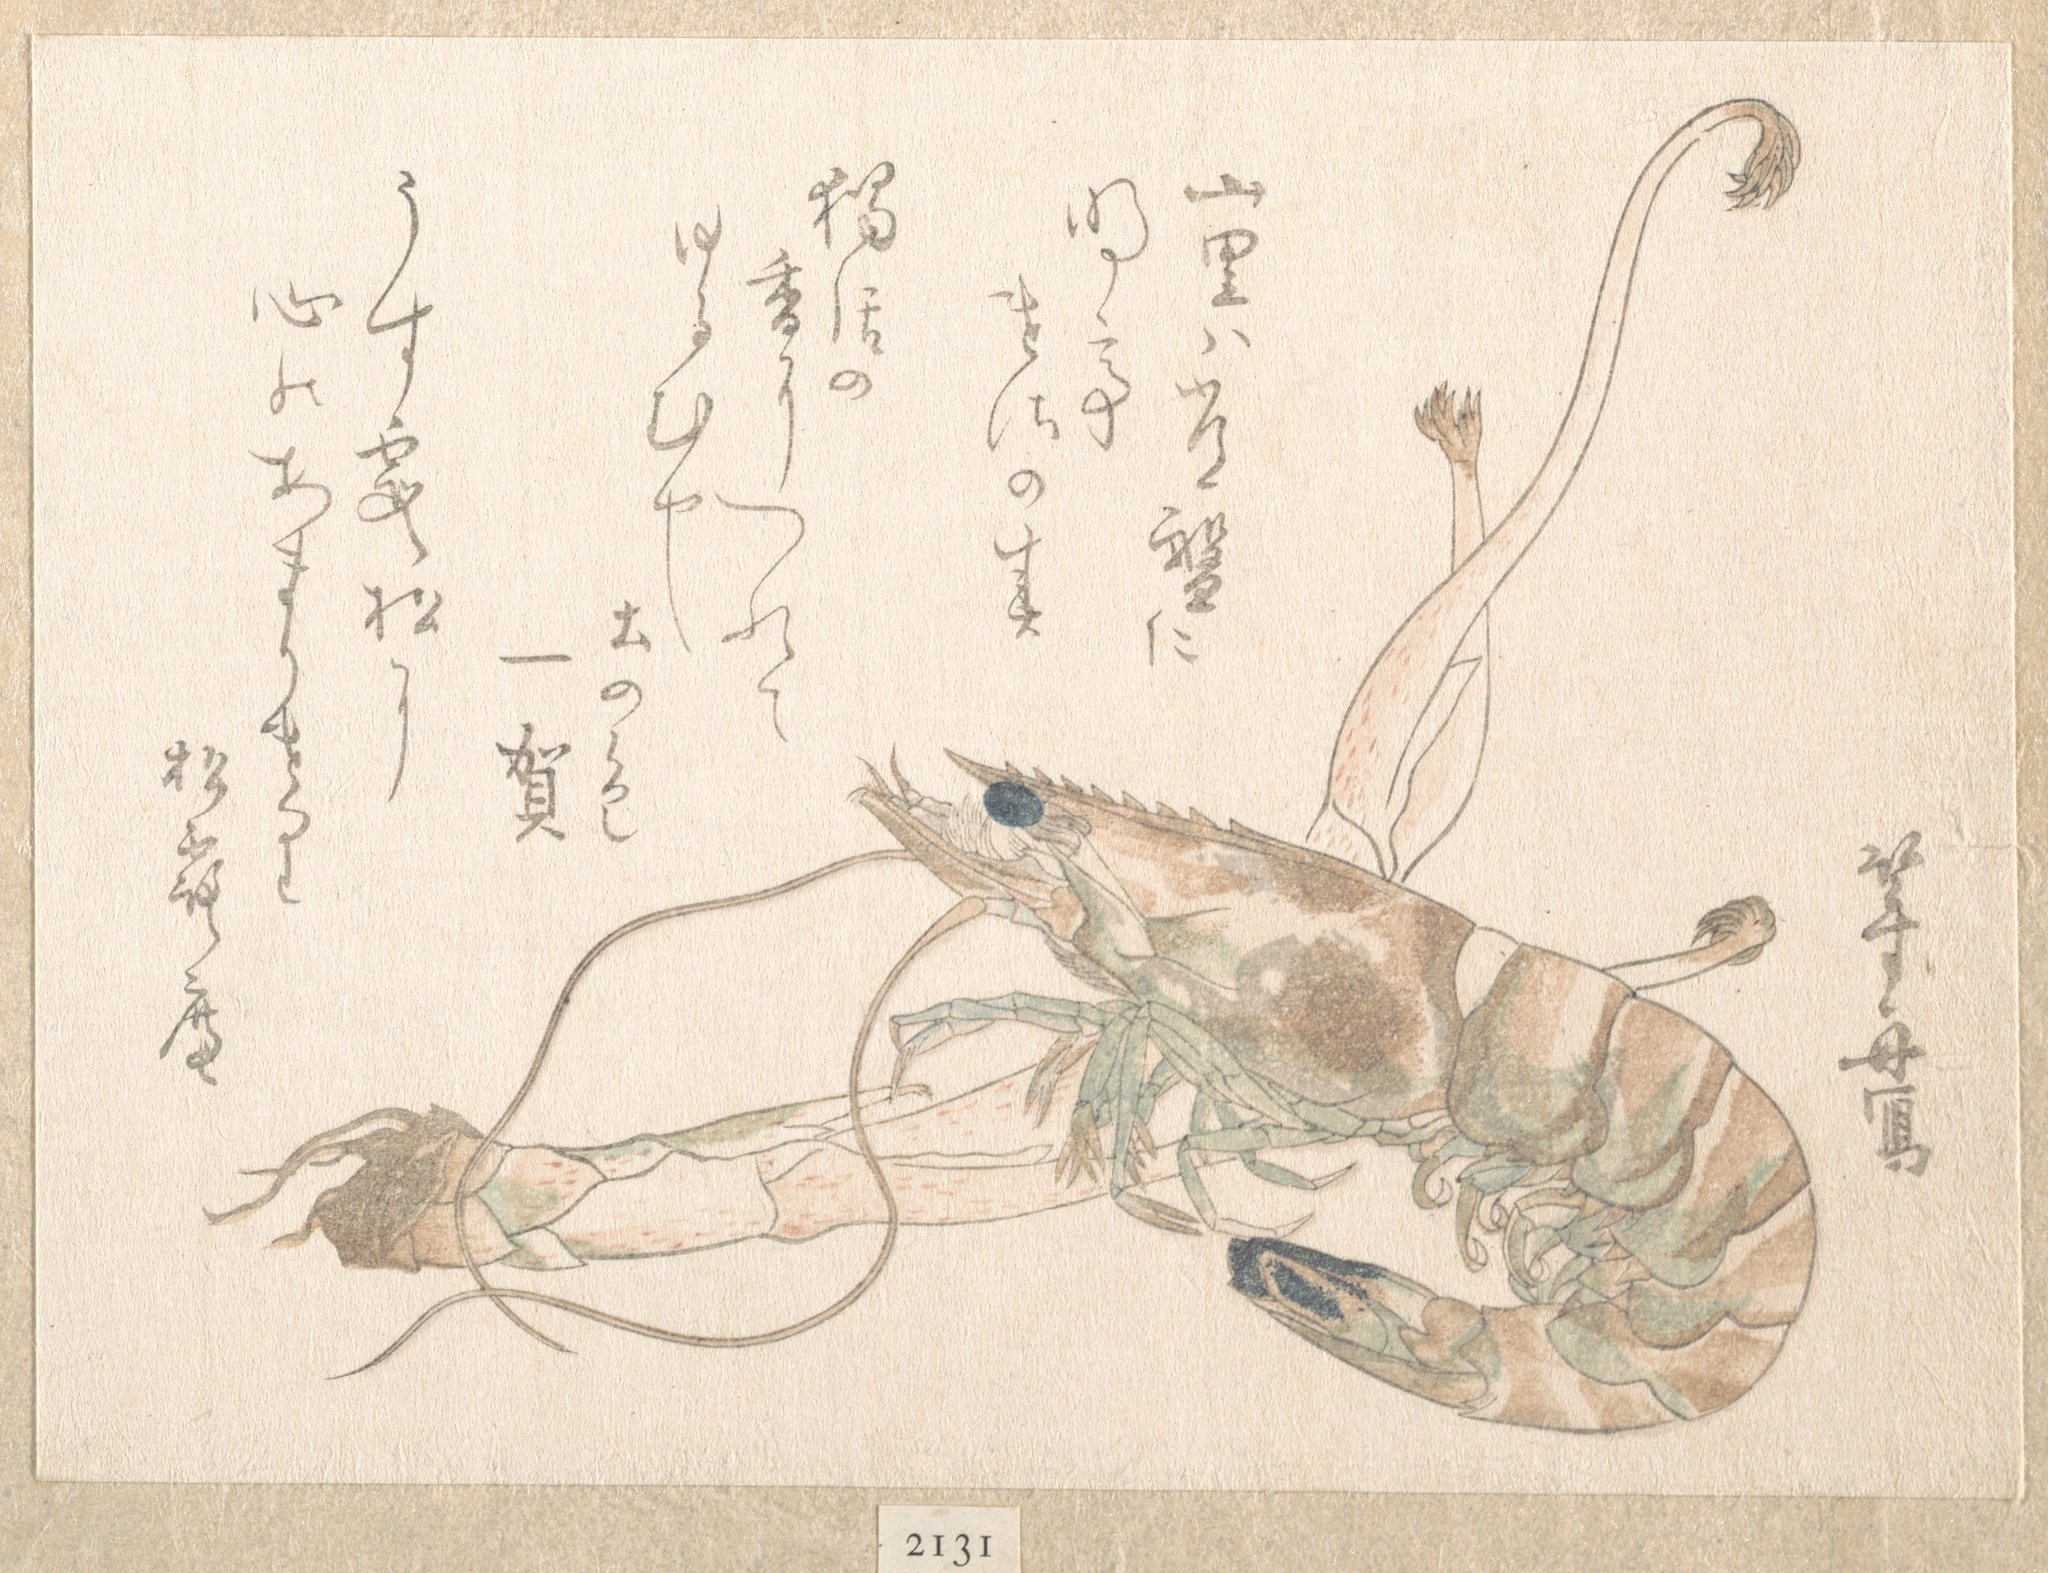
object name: print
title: Shrimp and Udo Plant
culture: japanese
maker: uematsu tōshū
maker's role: artist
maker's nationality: japanese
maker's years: 1810-1830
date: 1615-1868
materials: ink, paper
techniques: surimono, woodblock print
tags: lobsters